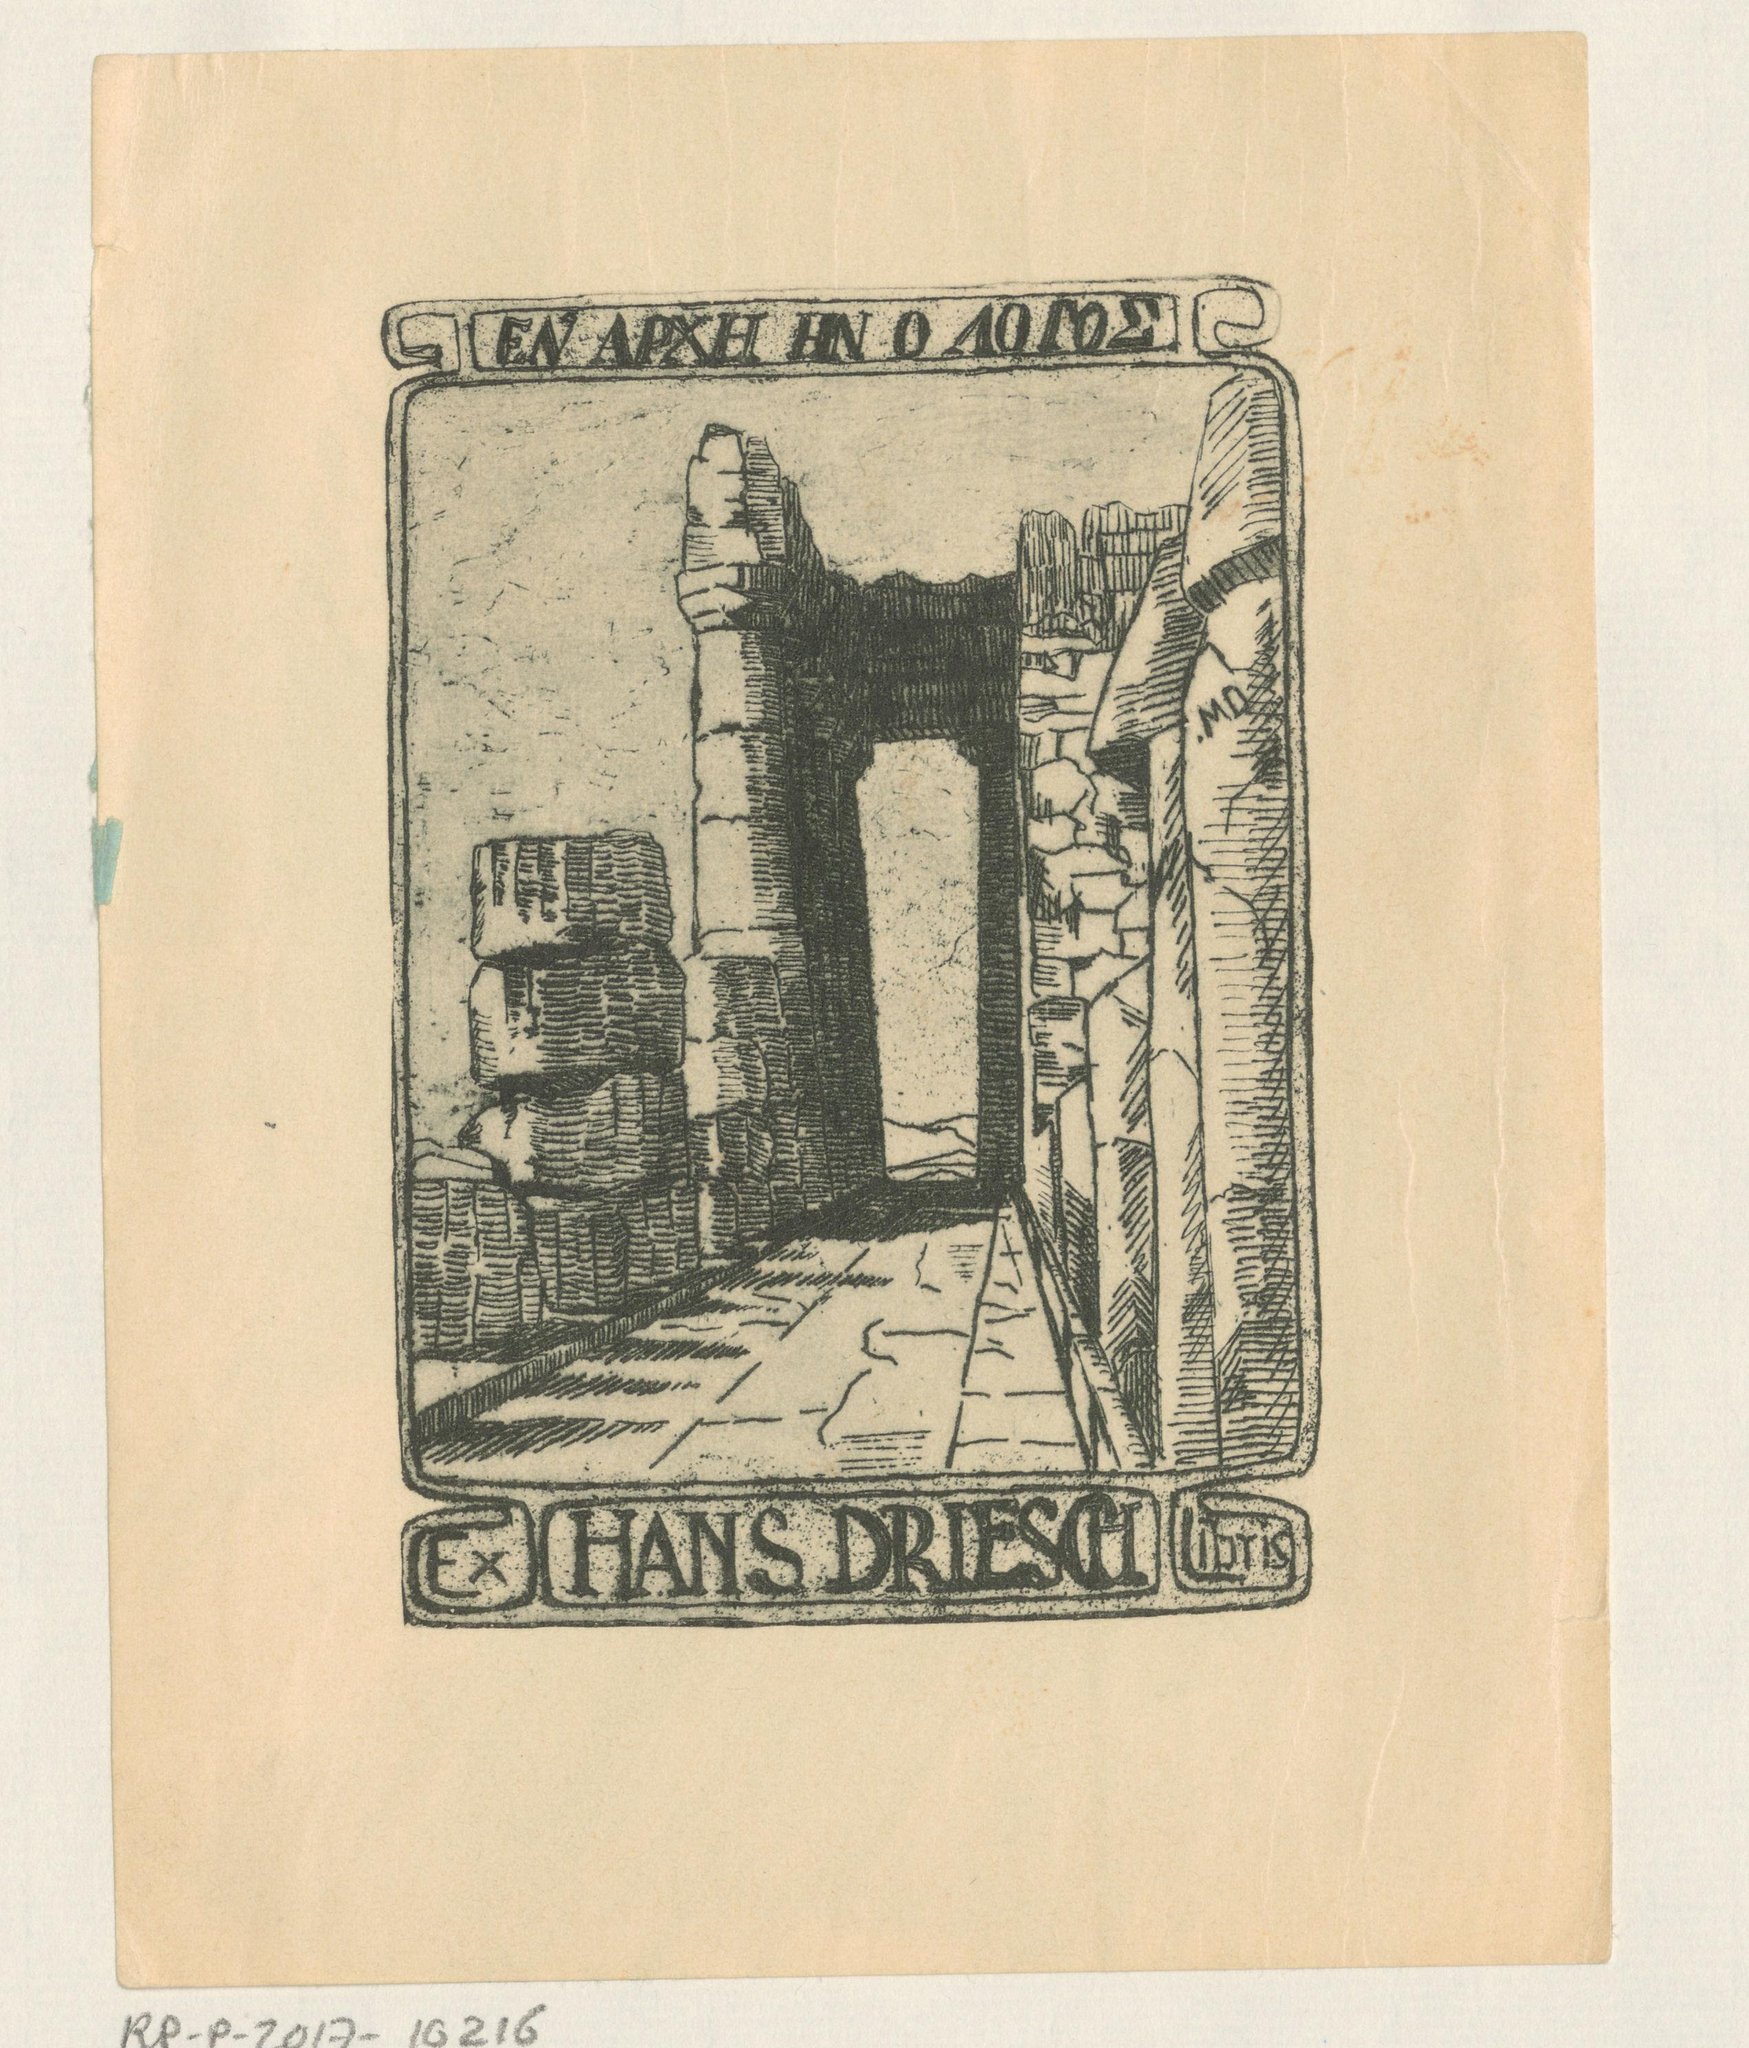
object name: photomechanical print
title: Εν αρχη ην ο λογος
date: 1884-1941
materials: paper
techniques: photoaquatint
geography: germany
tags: ruin of a building ~ architecture, temple, shrine ~ greek religion